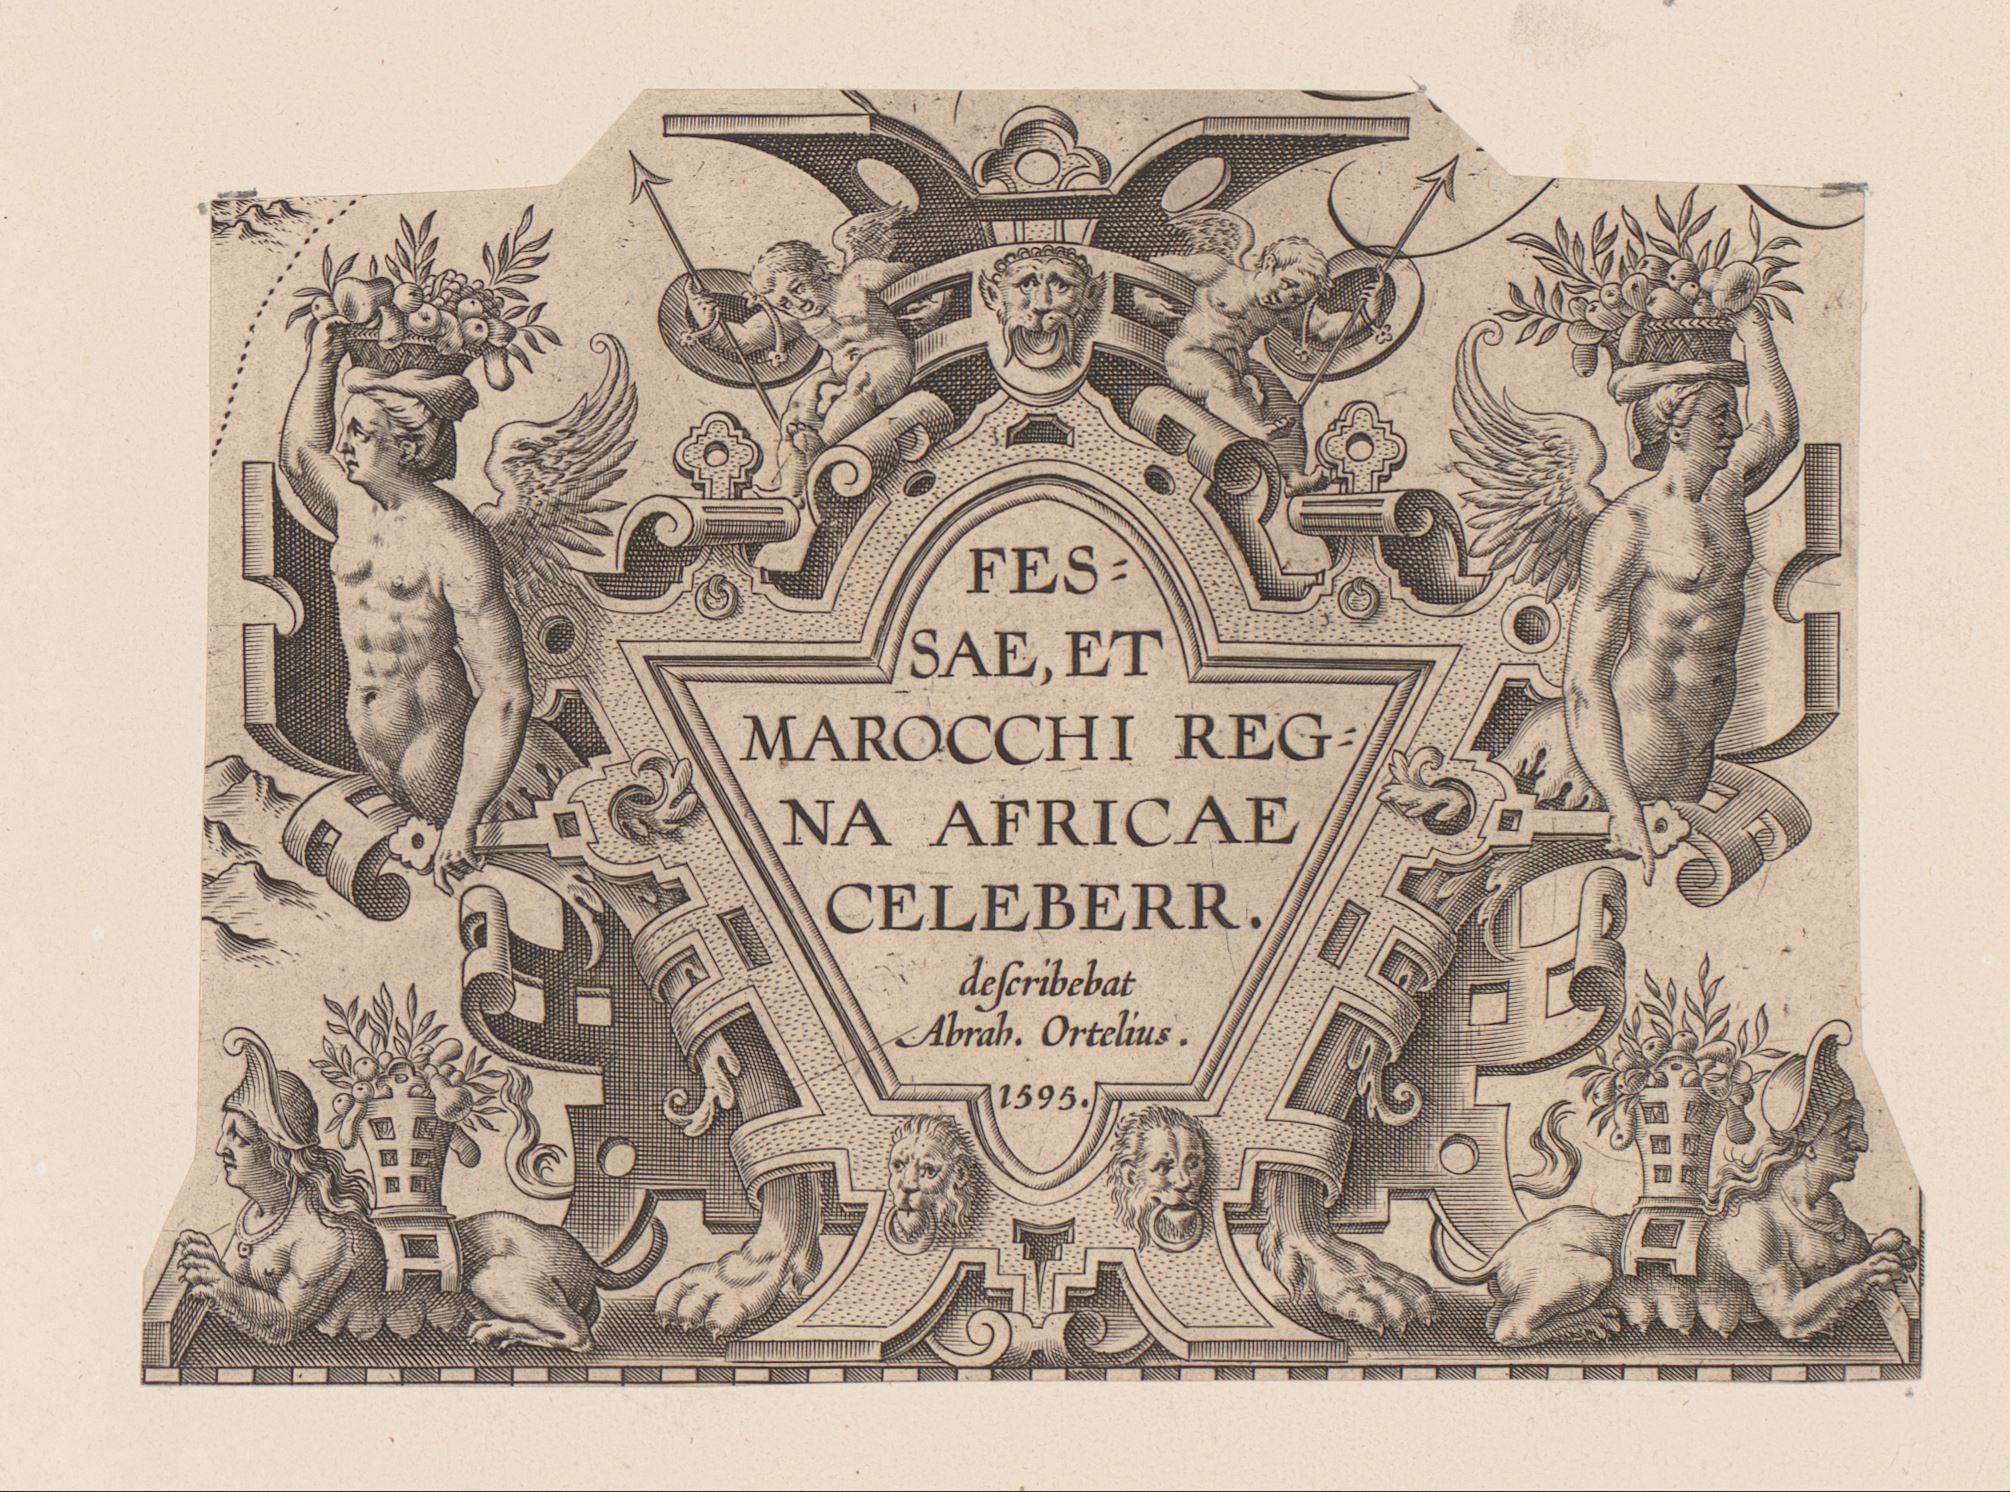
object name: album leaf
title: Cartouche met twee gevleugelde vrouwen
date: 1595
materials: paper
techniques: engraving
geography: antwerp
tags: fabulous beings with wings - aa - female human figure, sphinx (lion/woman); 'sfinge' (ripa) - aa - female human figure, ornament ~ cartouche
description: Rolwerkcartouche met zowel links als rechts een leeuwenpoot die uitloopt in het bovenlichaam van een gevleugelde vrouw. Onderaan twee sfinxen met een bloemenmand op de rug. Bovenaan twee putti. De cartouche is een fragment van een kaart van Fez en Marokko. De prent maakt deel uit van een album.